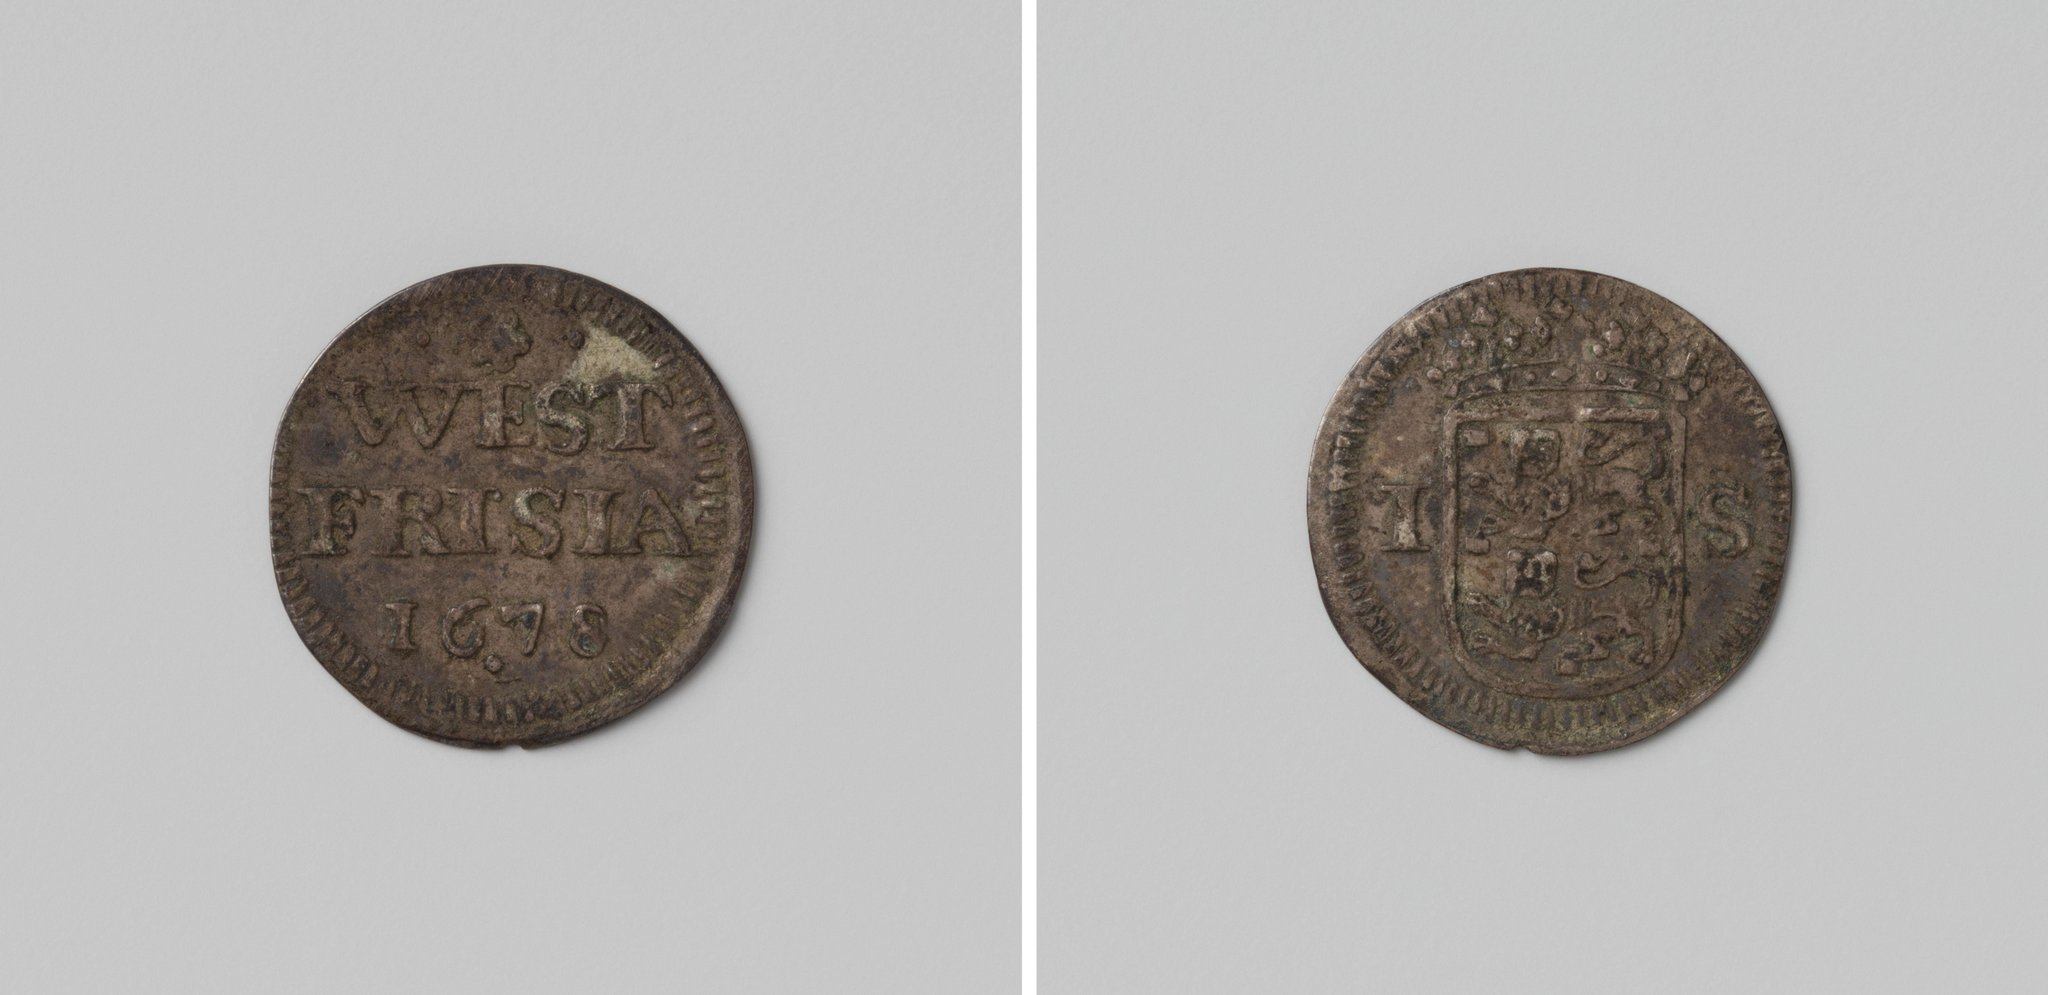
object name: coin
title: Stuiver van de provincie West-Friesland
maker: Anonymous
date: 1678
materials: silver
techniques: striking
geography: west frisia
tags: west-friesland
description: Voorzijde: opschrift boven jaartal. Keerzijde: gekroond wapenschild tussen waardeaanduiding